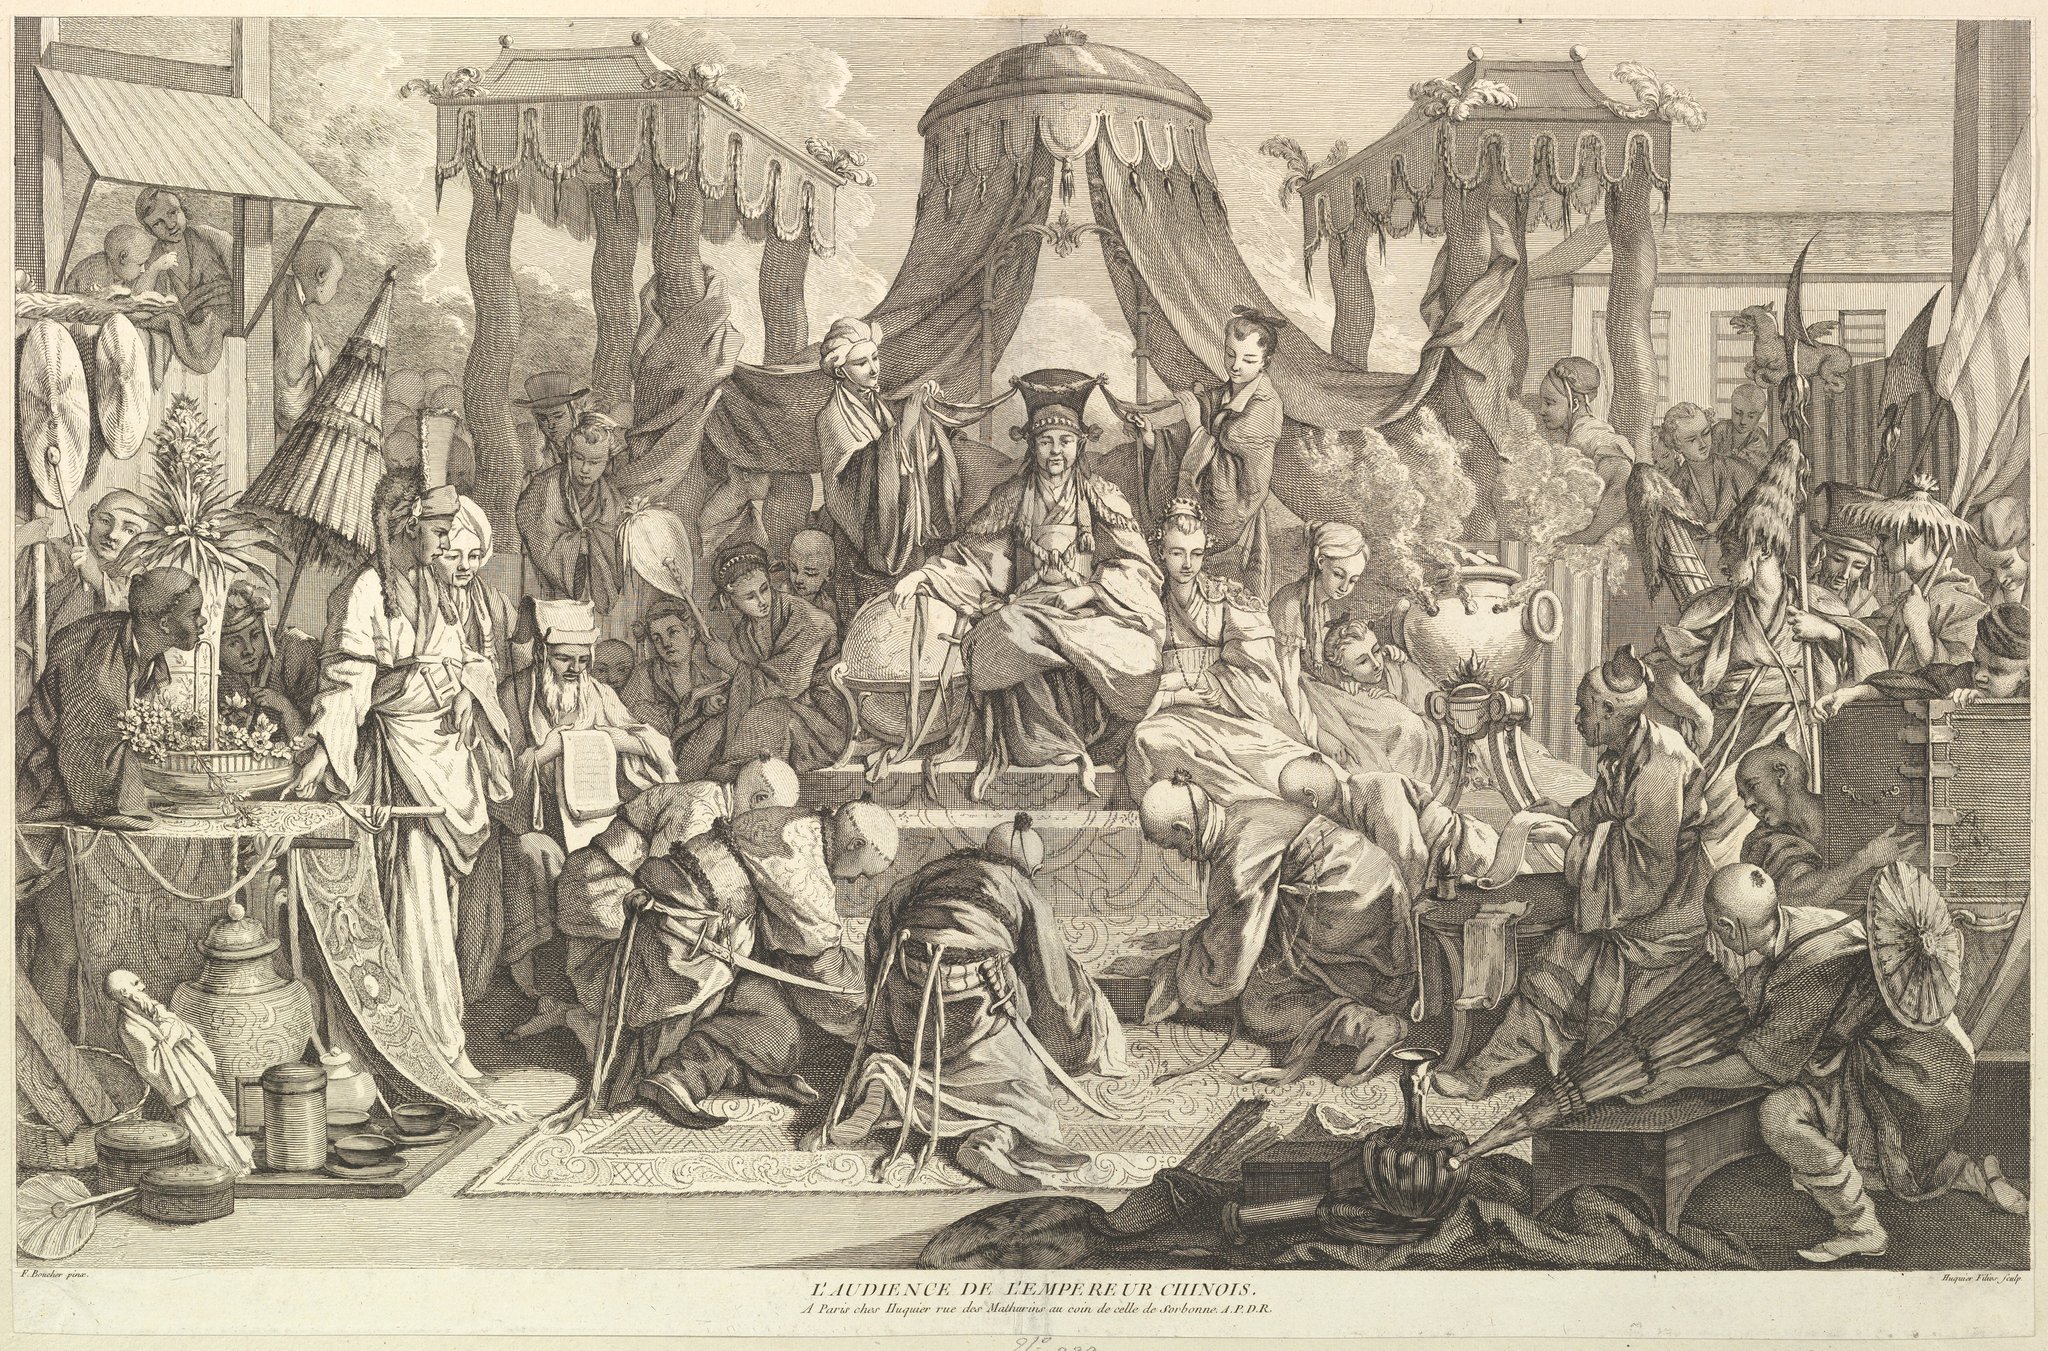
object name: collection ornament architecture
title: L'audience de l'Empereur chinois (The audience of the Chinese Emperor), from Chinoiseries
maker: jacques gabriel huquier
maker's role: artist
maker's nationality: french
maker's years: 1730-1805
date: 1743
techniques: engraving, etching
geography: france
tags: chinoiserie,emperors,men,women